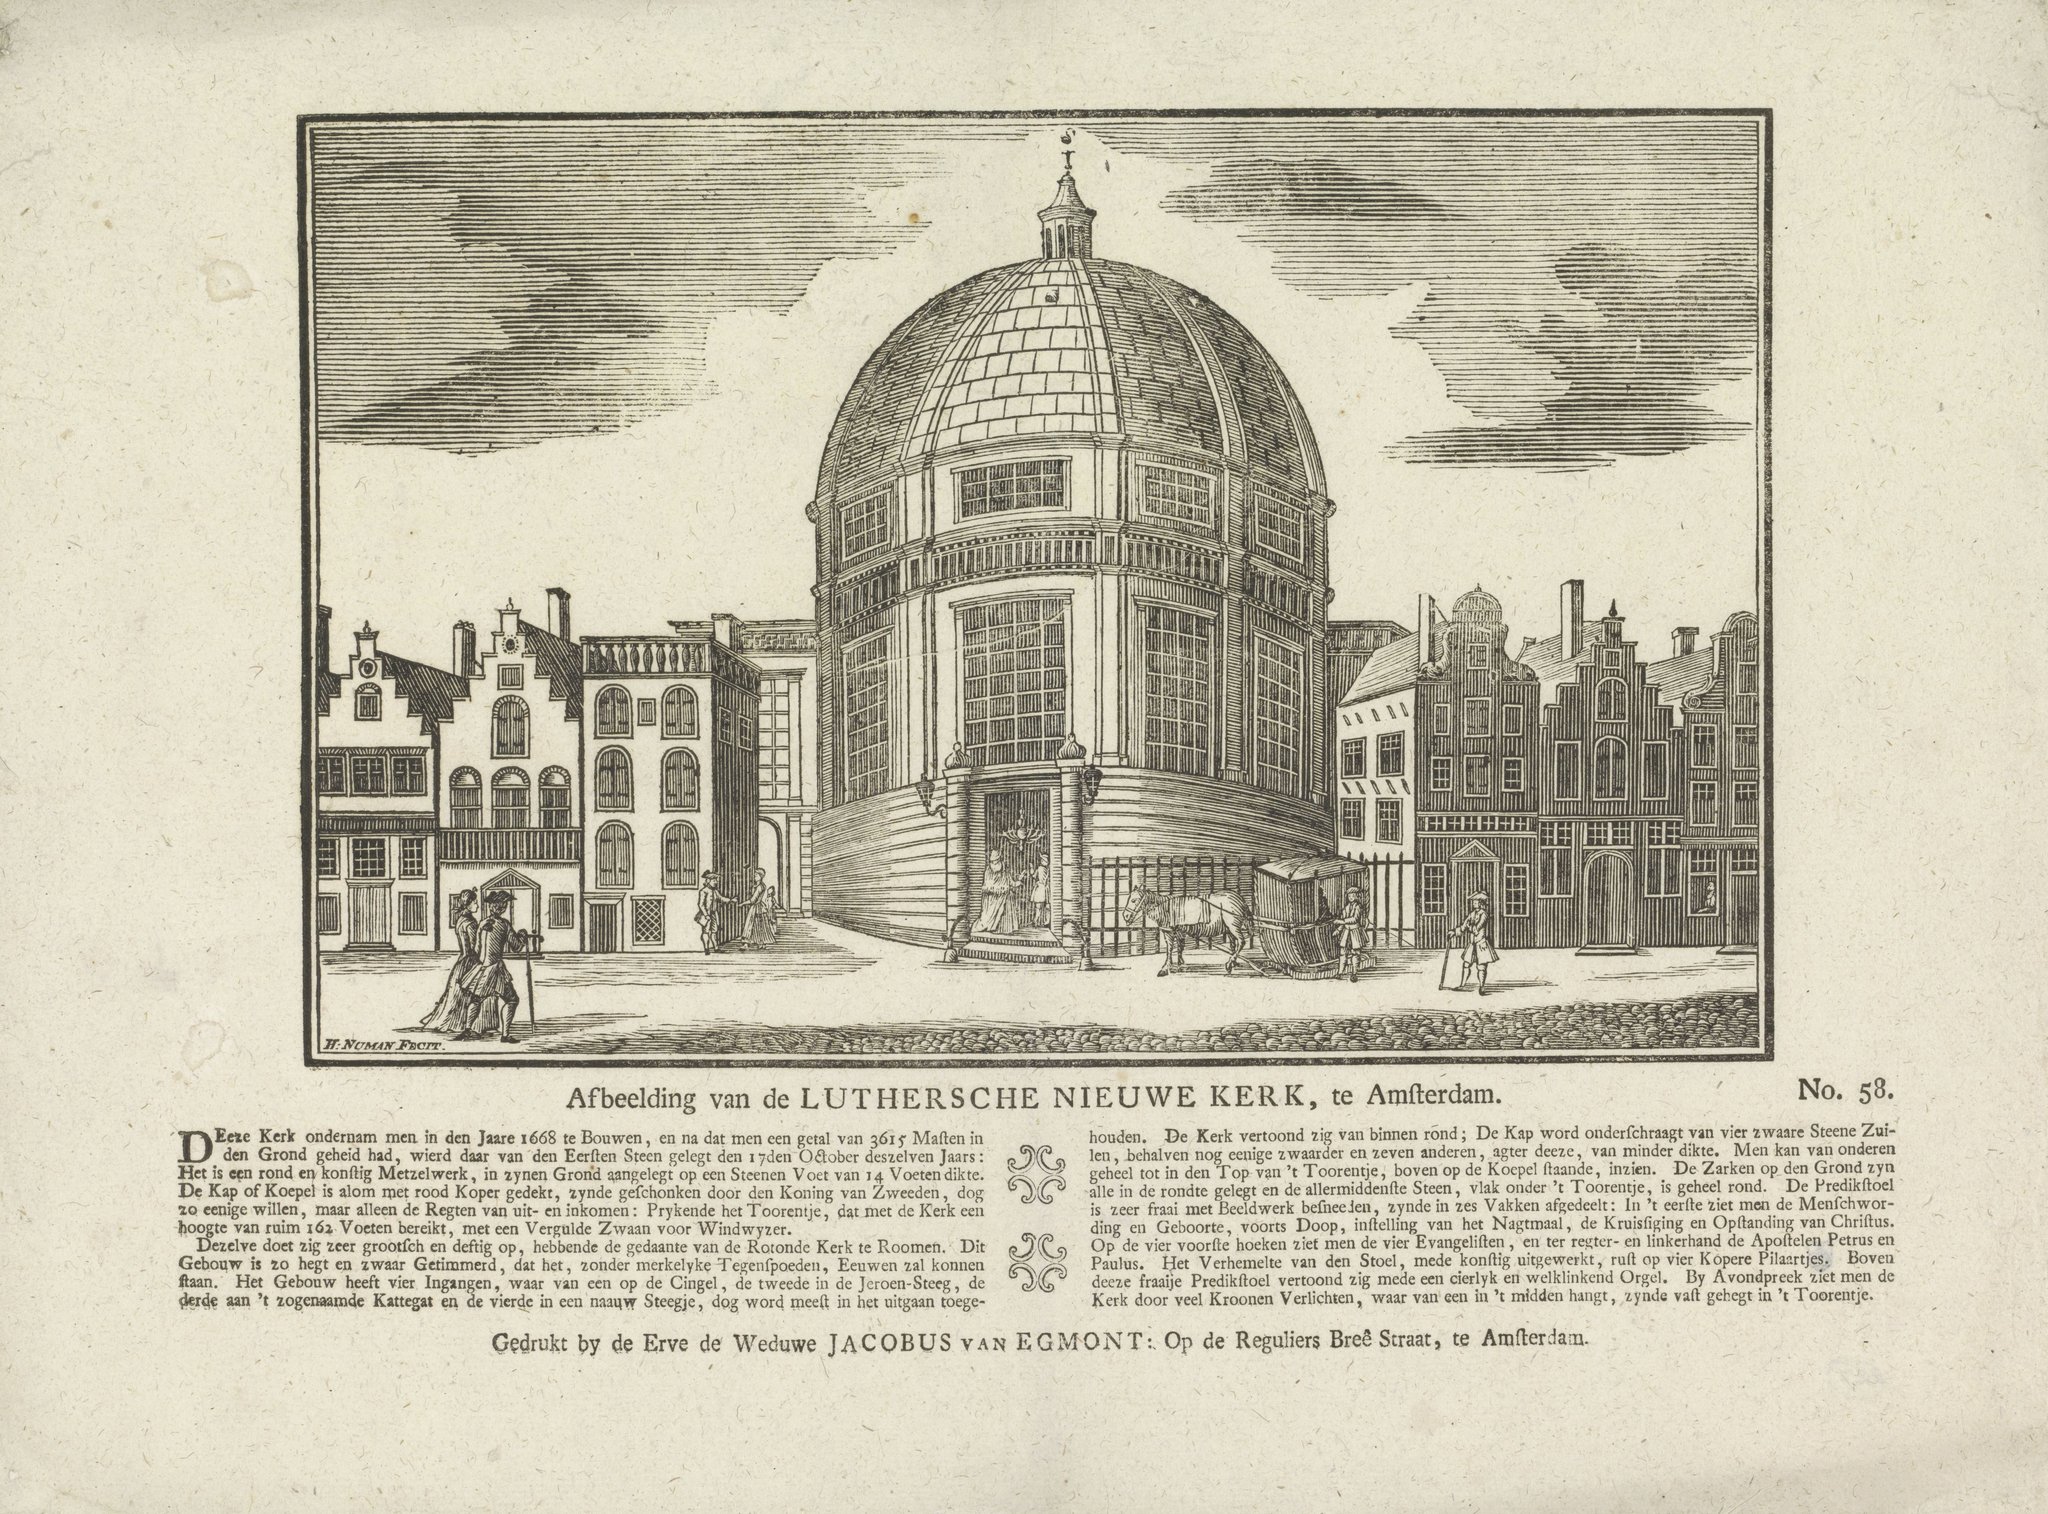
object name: popular print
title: Afbeelding van de Luthersche Nieuwe Kerk, te Amsterdam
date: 1761-1804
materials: paper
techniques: letterpress printing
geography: amsterdam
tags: church (exterior)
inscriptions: collector's mark: Lugt 2760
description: Blad met grote voorstelling van de Nieuwe Lutherse Kerk aan het Singel te Amsterdam (vóór de brand van 1820). Onder de voorstelling een onderschrift in twee kolommen. Genummerd midden rechts: No. 58.